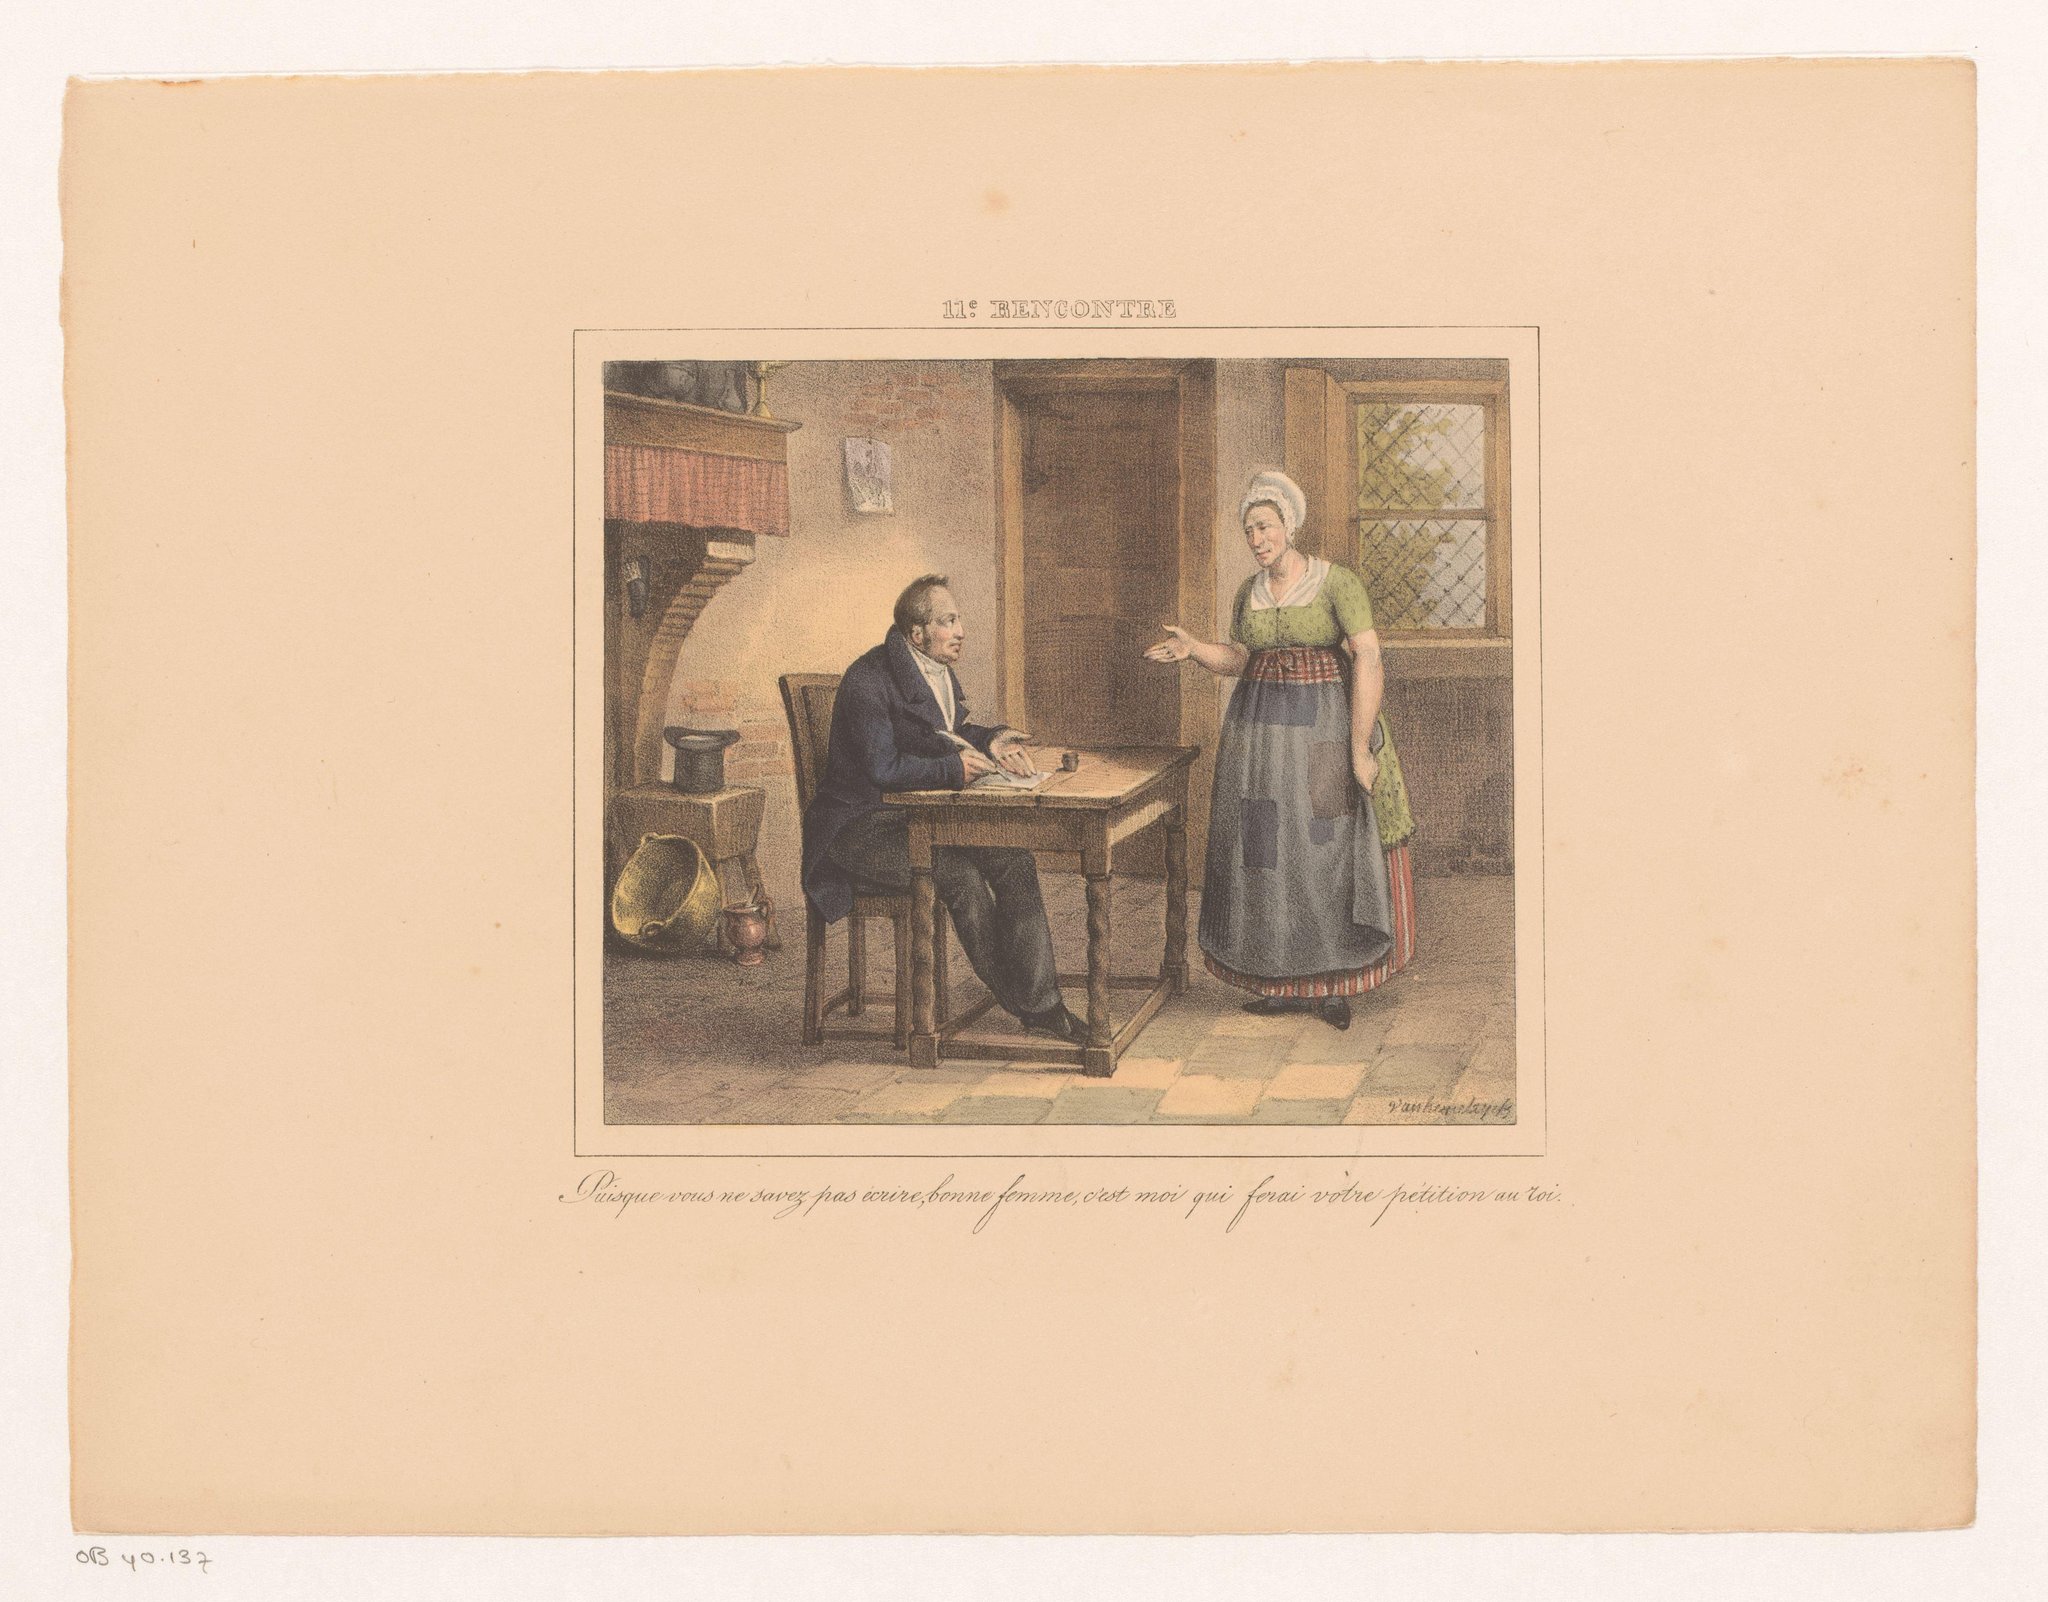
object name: print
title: Koning Willem I schrijft een request voor een vrouw, 1829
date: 1829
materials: paper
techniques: hand coloring, lithograph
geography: brussels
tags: the hague, berlin, william i of the netherlands, ruler in informal contact with his subjects, writing and letters, letter, envelope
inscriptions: collector's mark: Lugt 2228, inscription: ‘c'est moi qui ferai votre petition au roi’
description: De koning schrijft in de woning van een vrouw die niet kan schrijven een verzoekschrift aan de koning. Met eenregelig onderschrift. Onderdeel van de serie van 24 platen met ontmoetingen met koning Willem I, verschenen onder de titel 'Les rencontres' in 1829-1830.